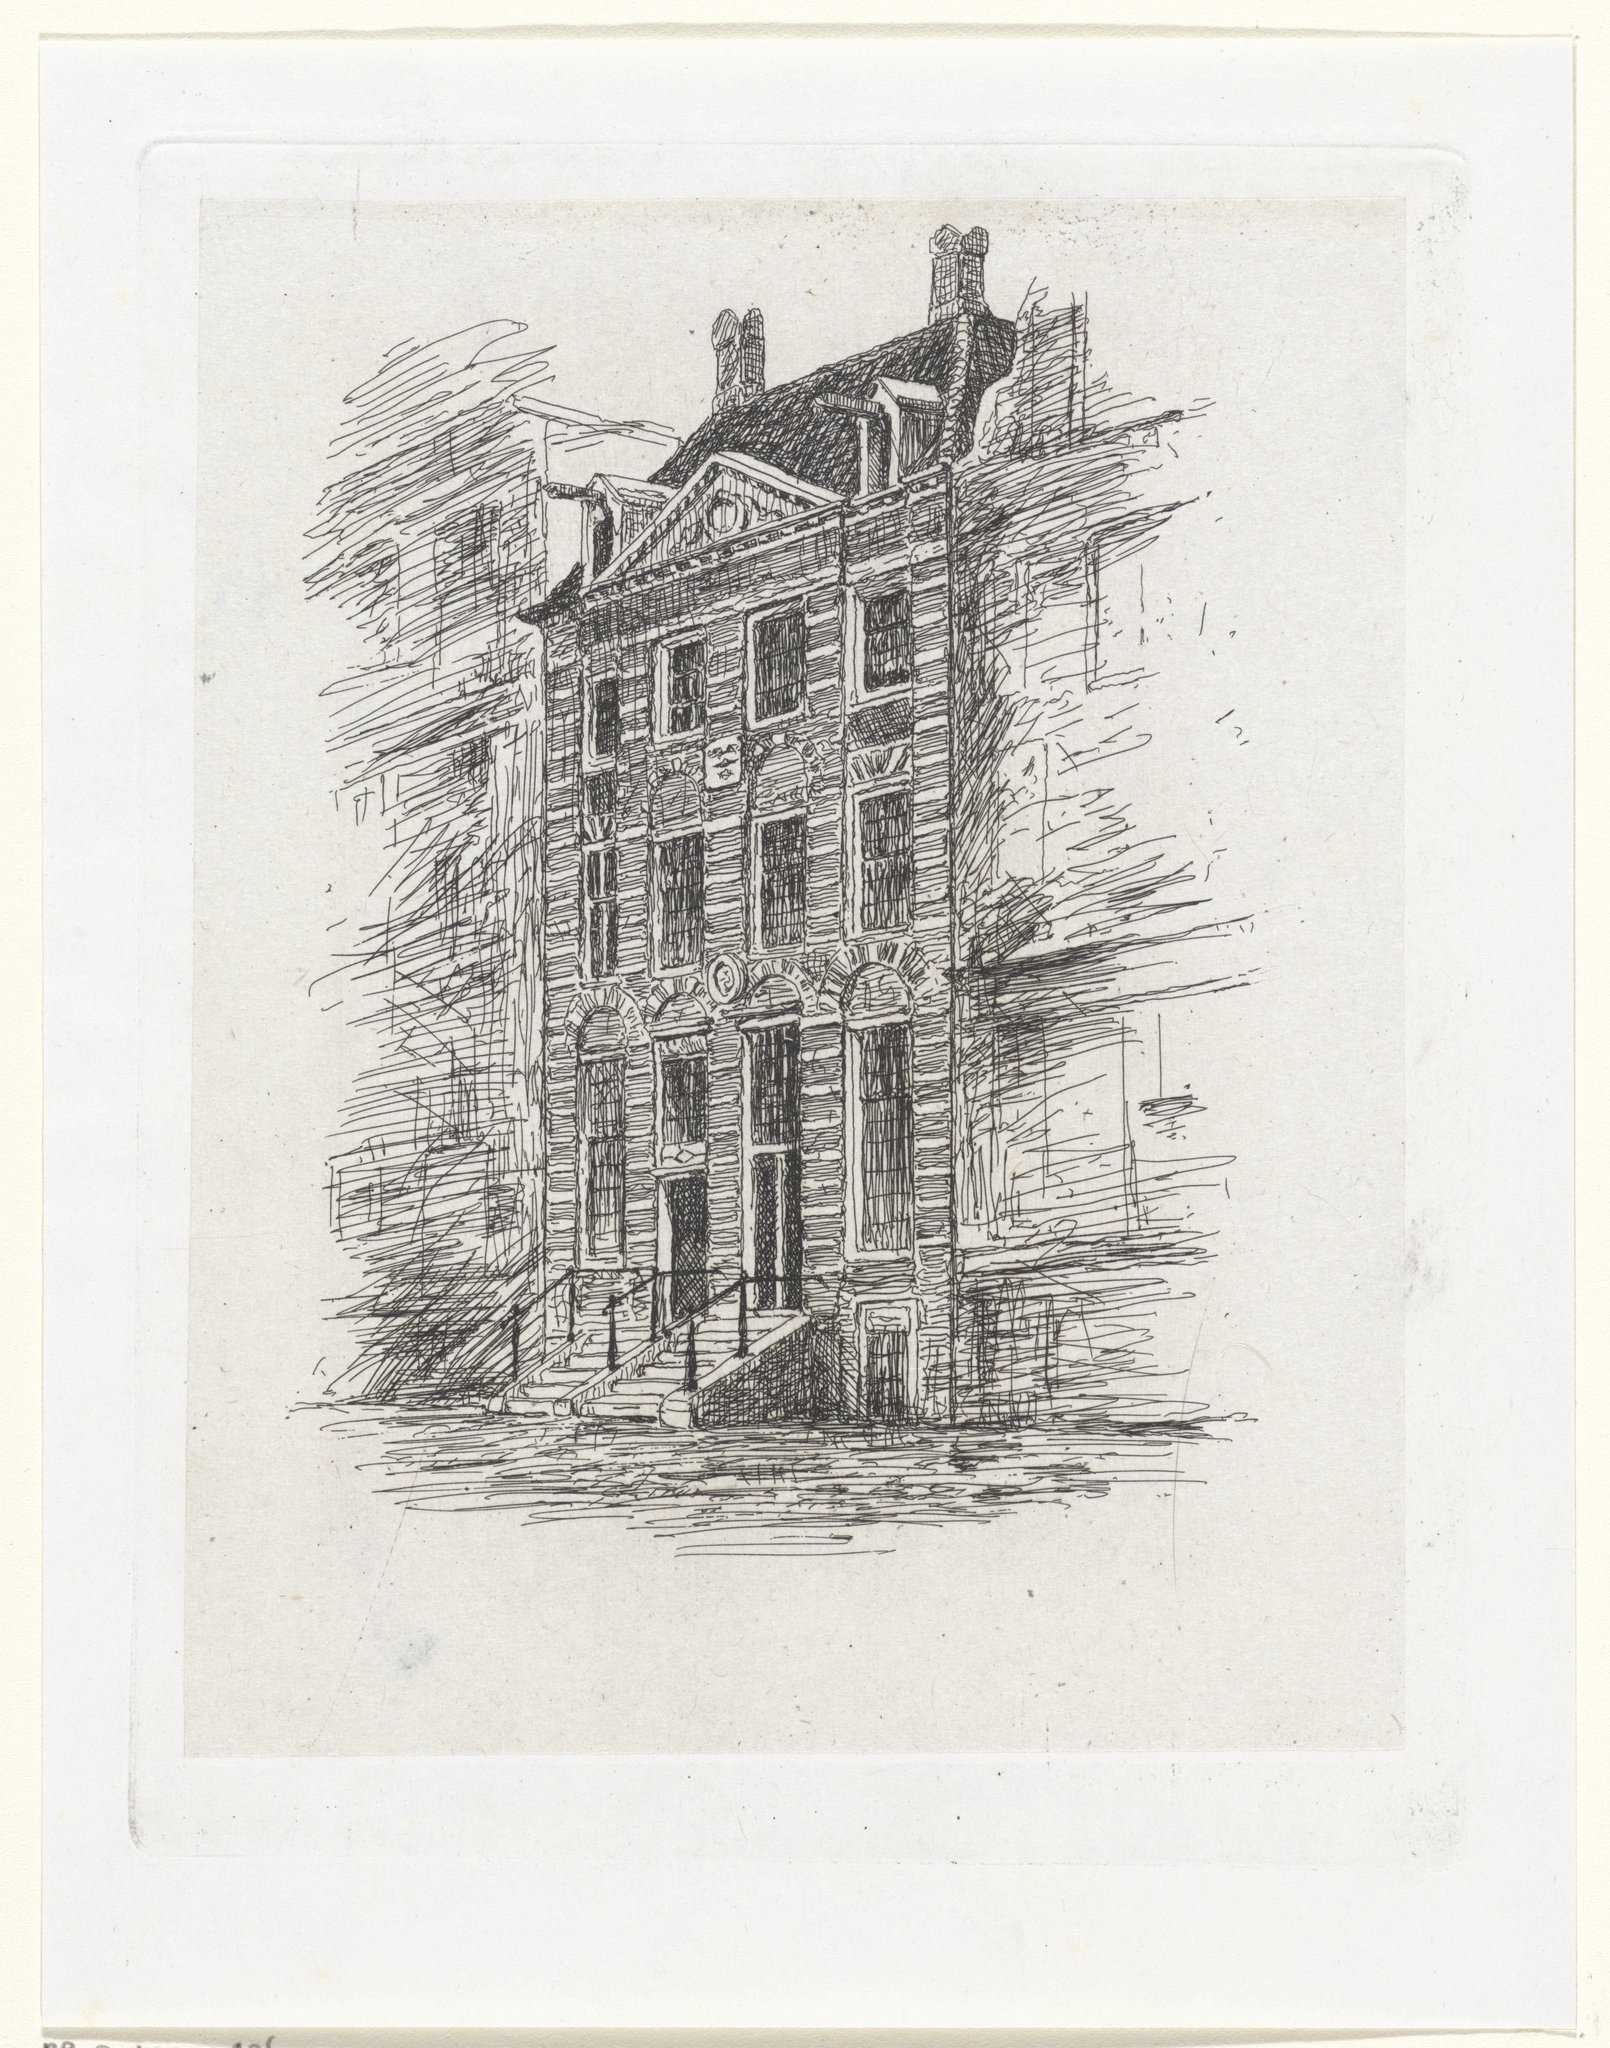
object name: print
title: Rembrandthuis, versie B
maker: jan weissenbruch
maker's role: painter, print maker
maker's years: 1822-1880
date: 1837-1880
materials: paper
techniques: etching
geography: amsterdam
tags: urban housing